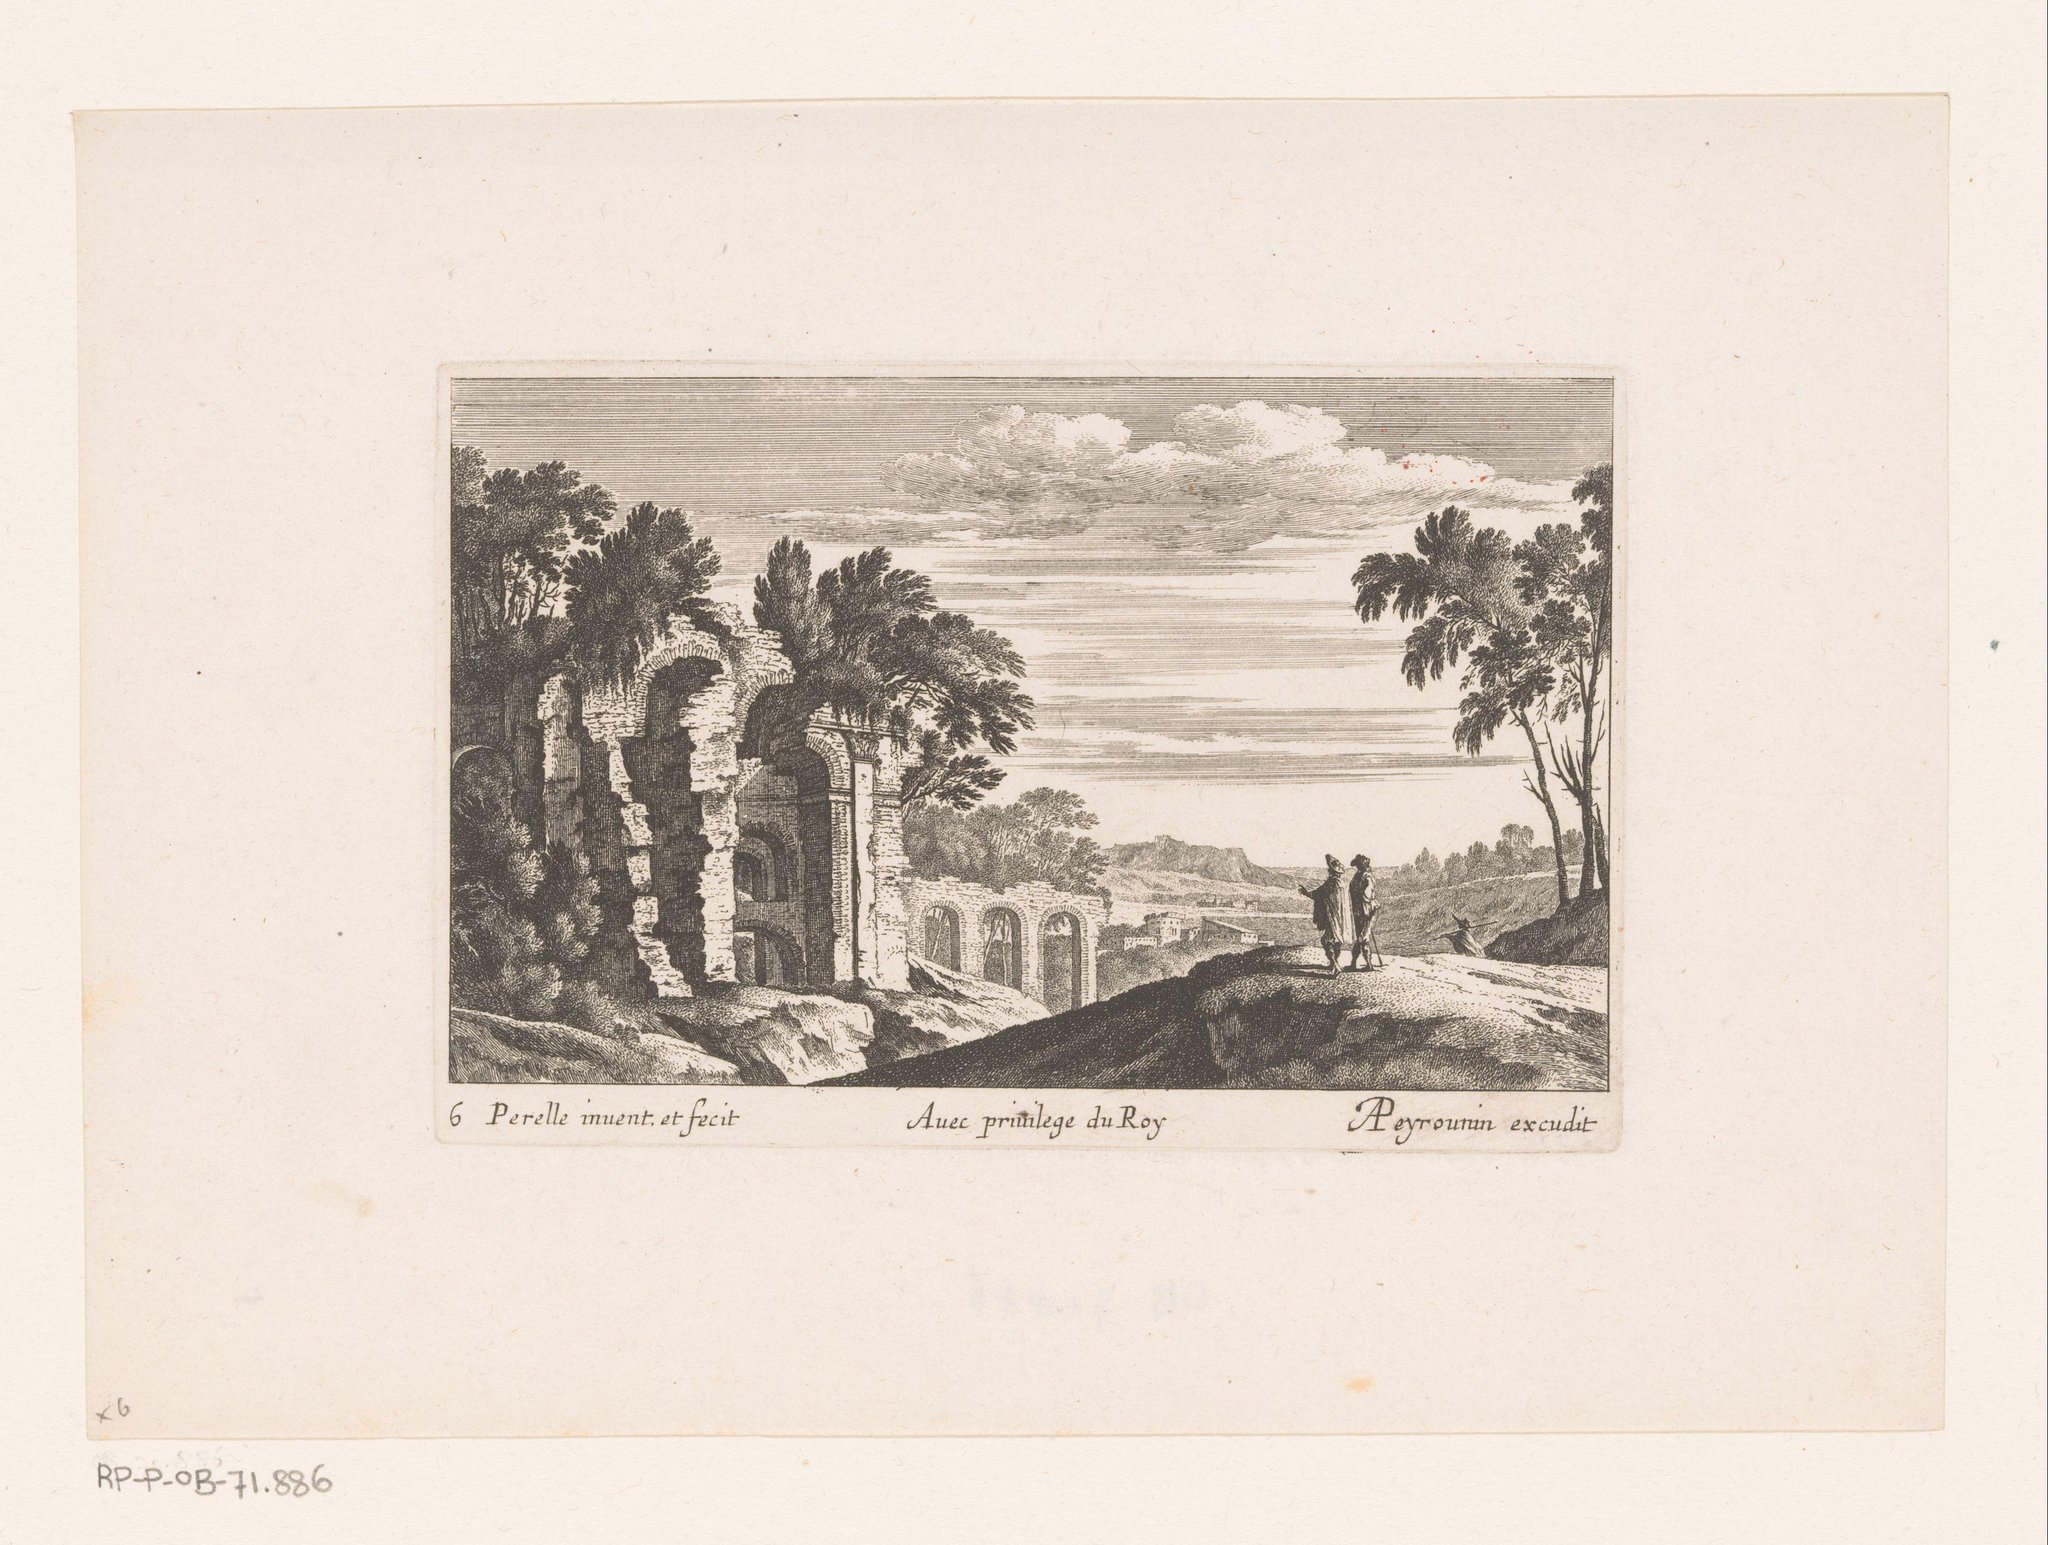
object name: print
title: Wandelaars bij ruïne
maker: abraham peyrounin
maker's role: publisher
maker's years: 1620-1666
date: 1613-1695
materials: paper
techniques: etching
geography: france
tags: landscape with ruins (+ city(-scape) with figures, staffage)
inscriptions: collector's mark: Lugt 240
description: Prenten met het signatuur 'Perelle' kunnen zowel door vader Gabriel als door zonen Nicolas en Adam gemaakt zijn.